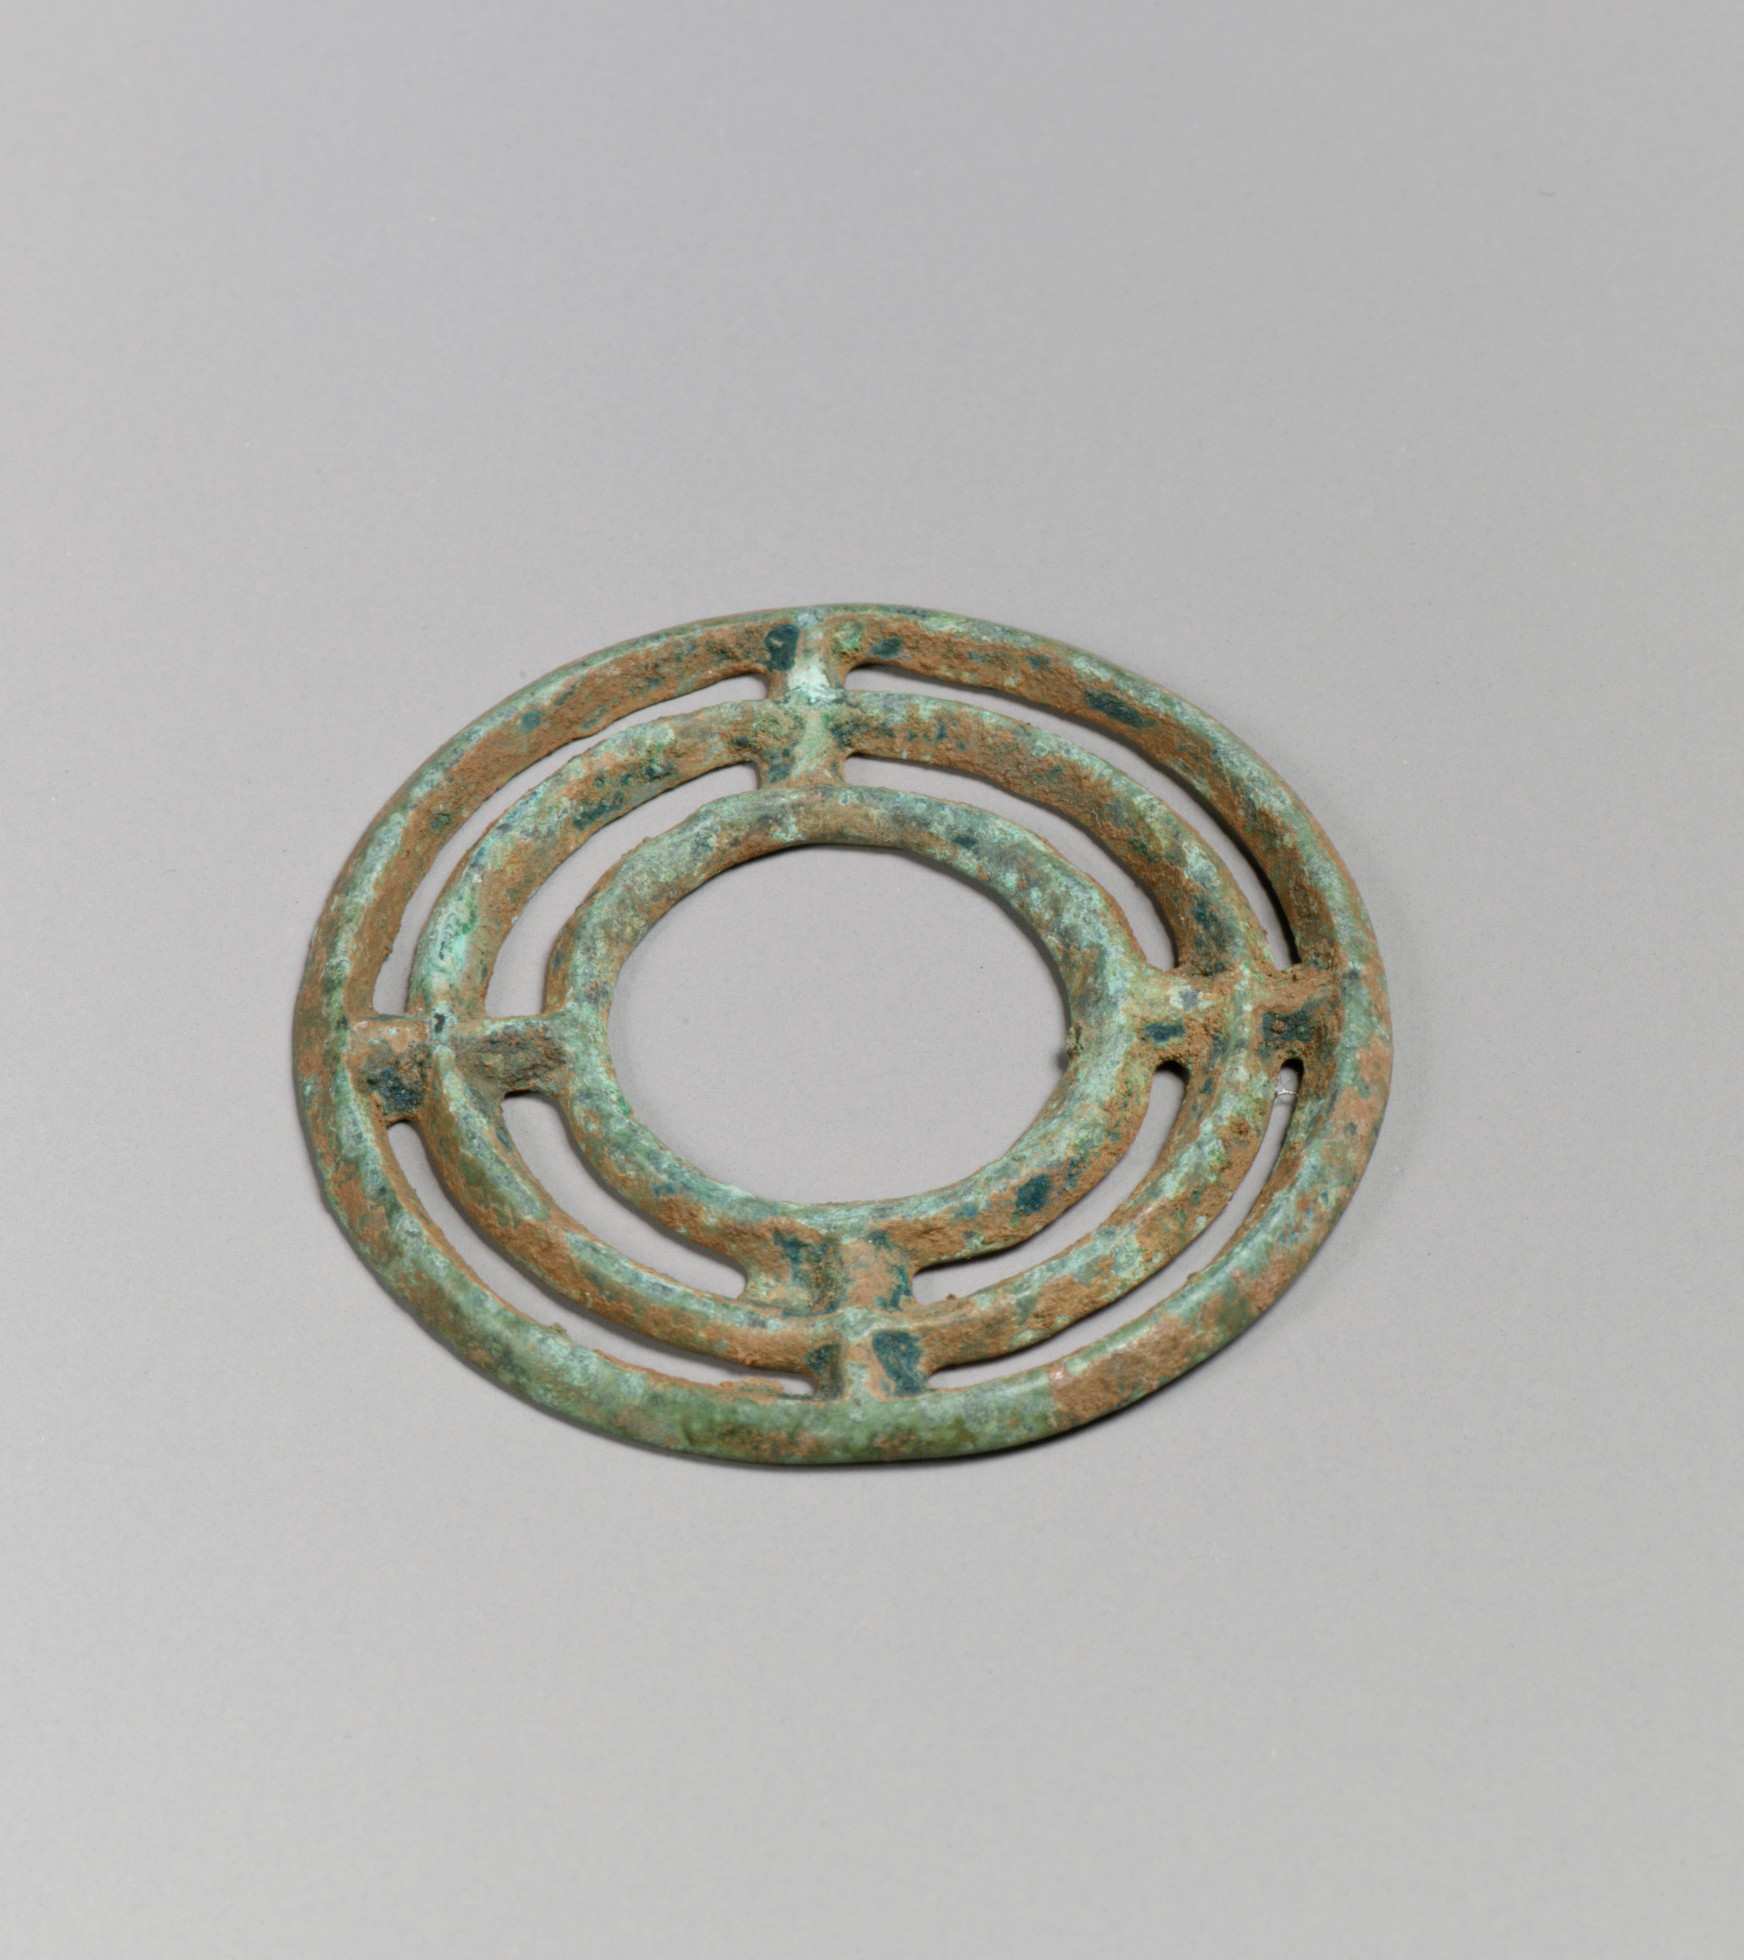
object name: necklace spiral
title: Bronze necklace spiral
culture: italic, villanovan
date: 900-701 BCE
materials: bronze